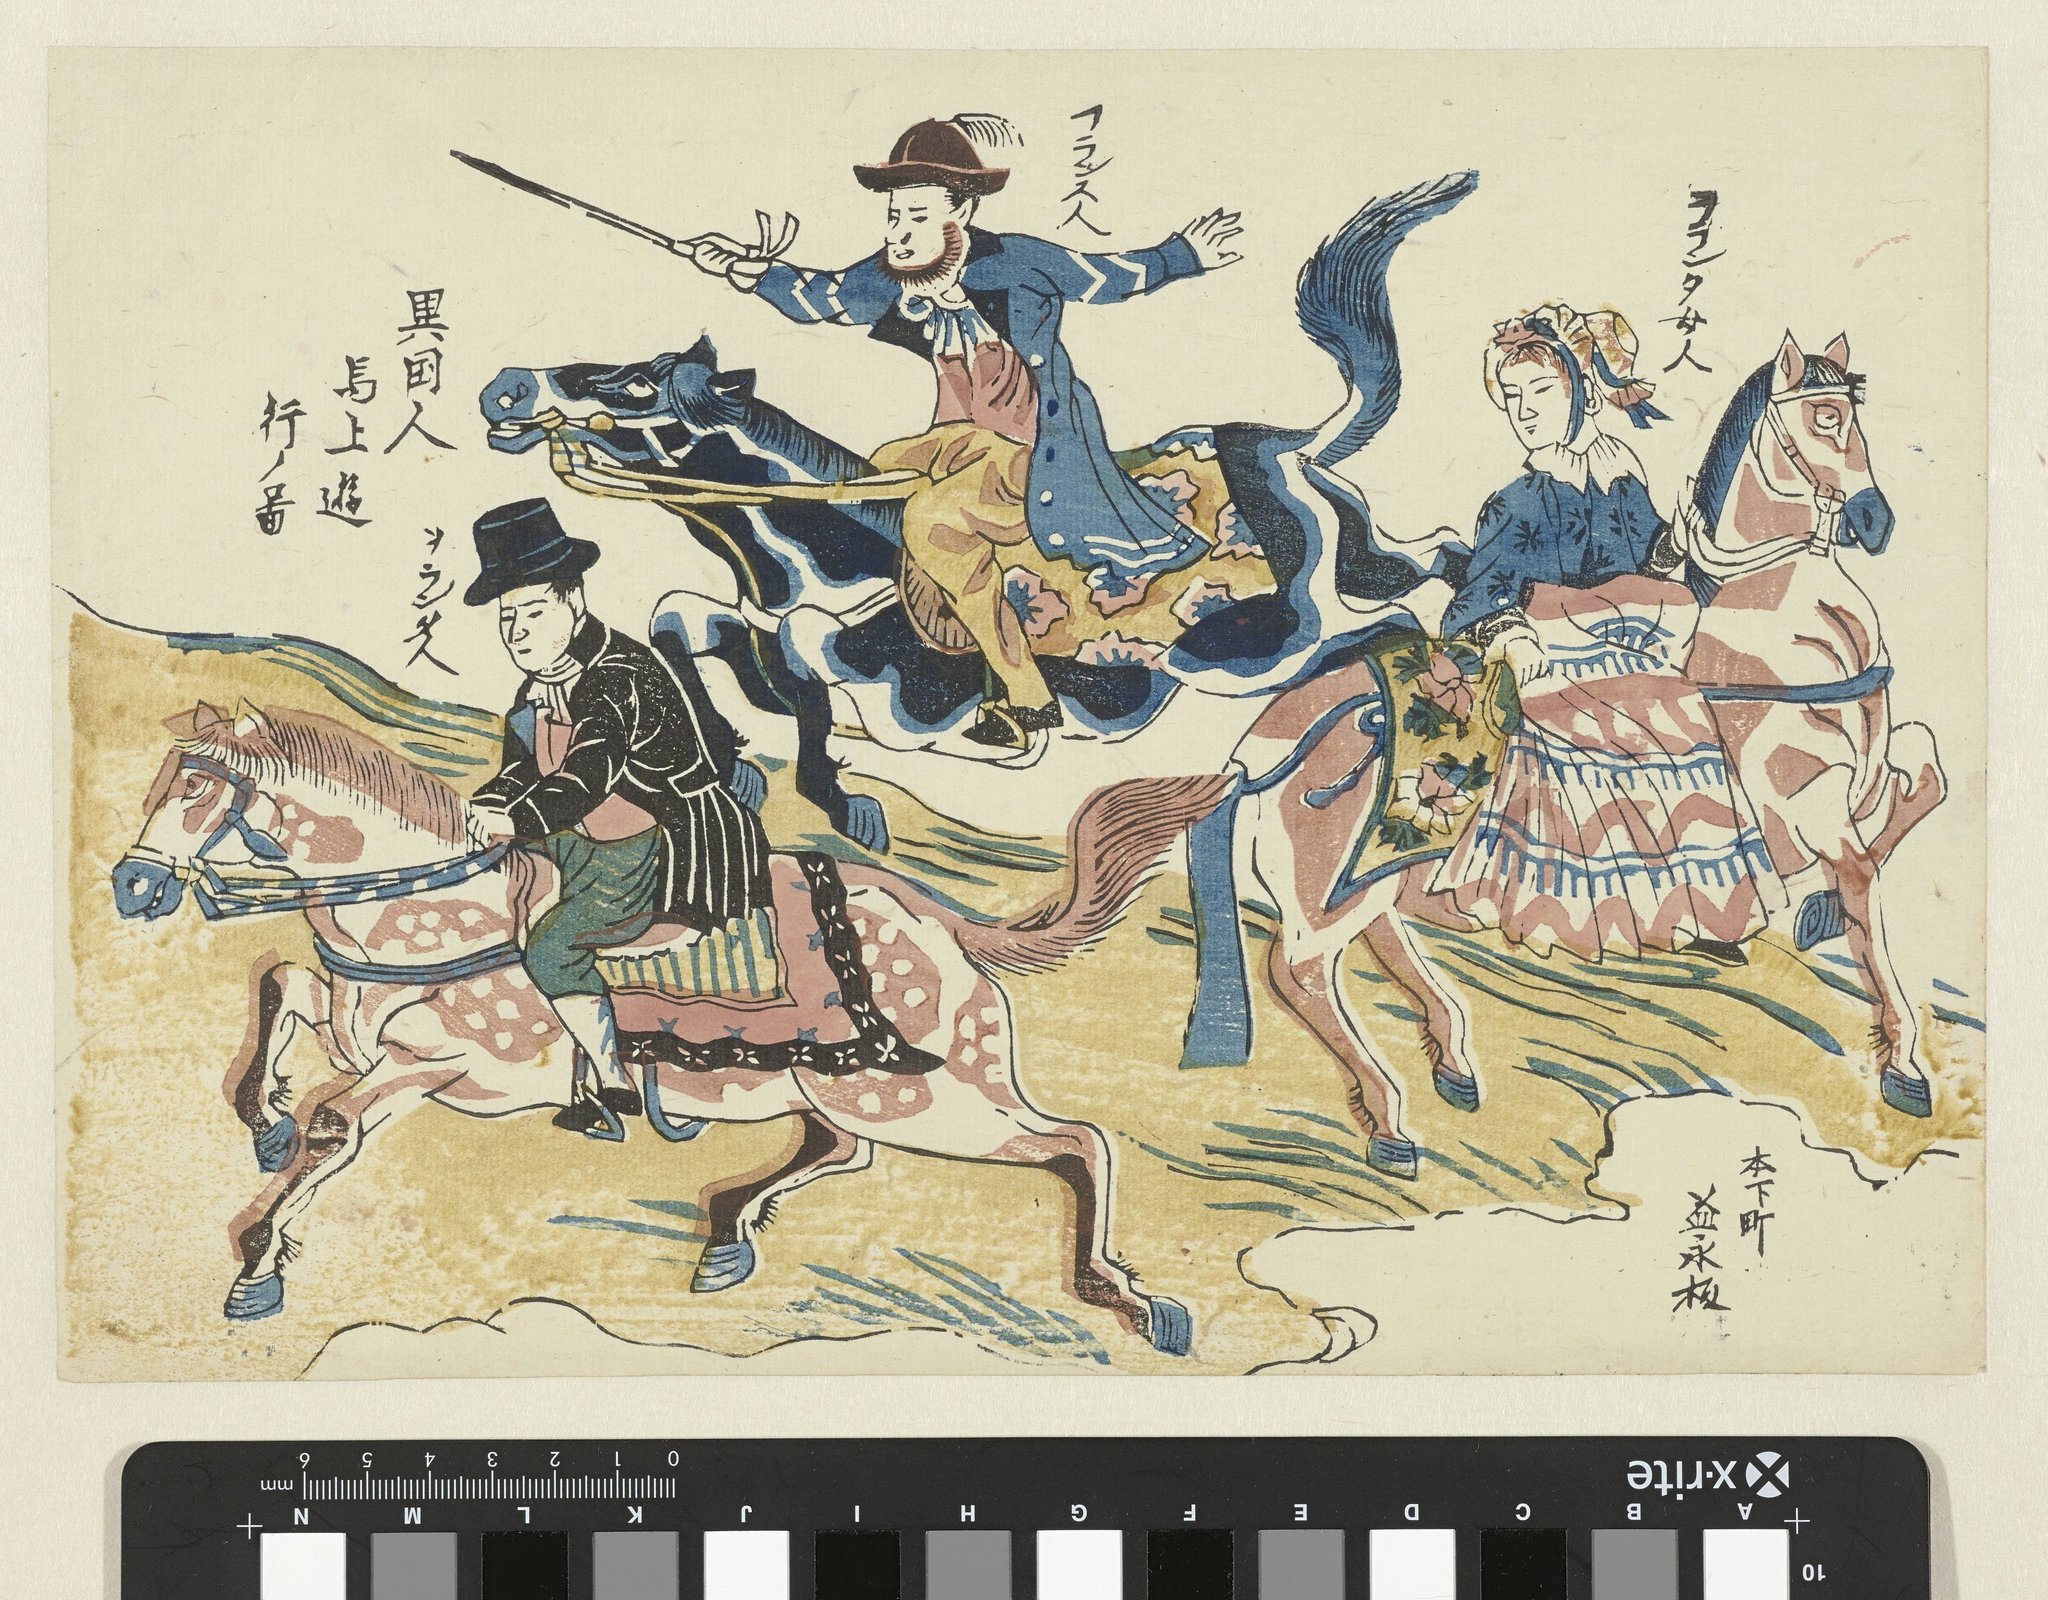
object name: print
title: Ikokujin bajo yuko no zu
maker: Anonymous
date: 1740-1864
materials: paper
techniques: woodcut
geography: nagasaki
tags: riding a horse, ass, or mule; rider, horseman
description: Een Nederlander, een Fransman met getrokken zwaard en een Nederlandse vrouw te paard. (Nagasaki-e).